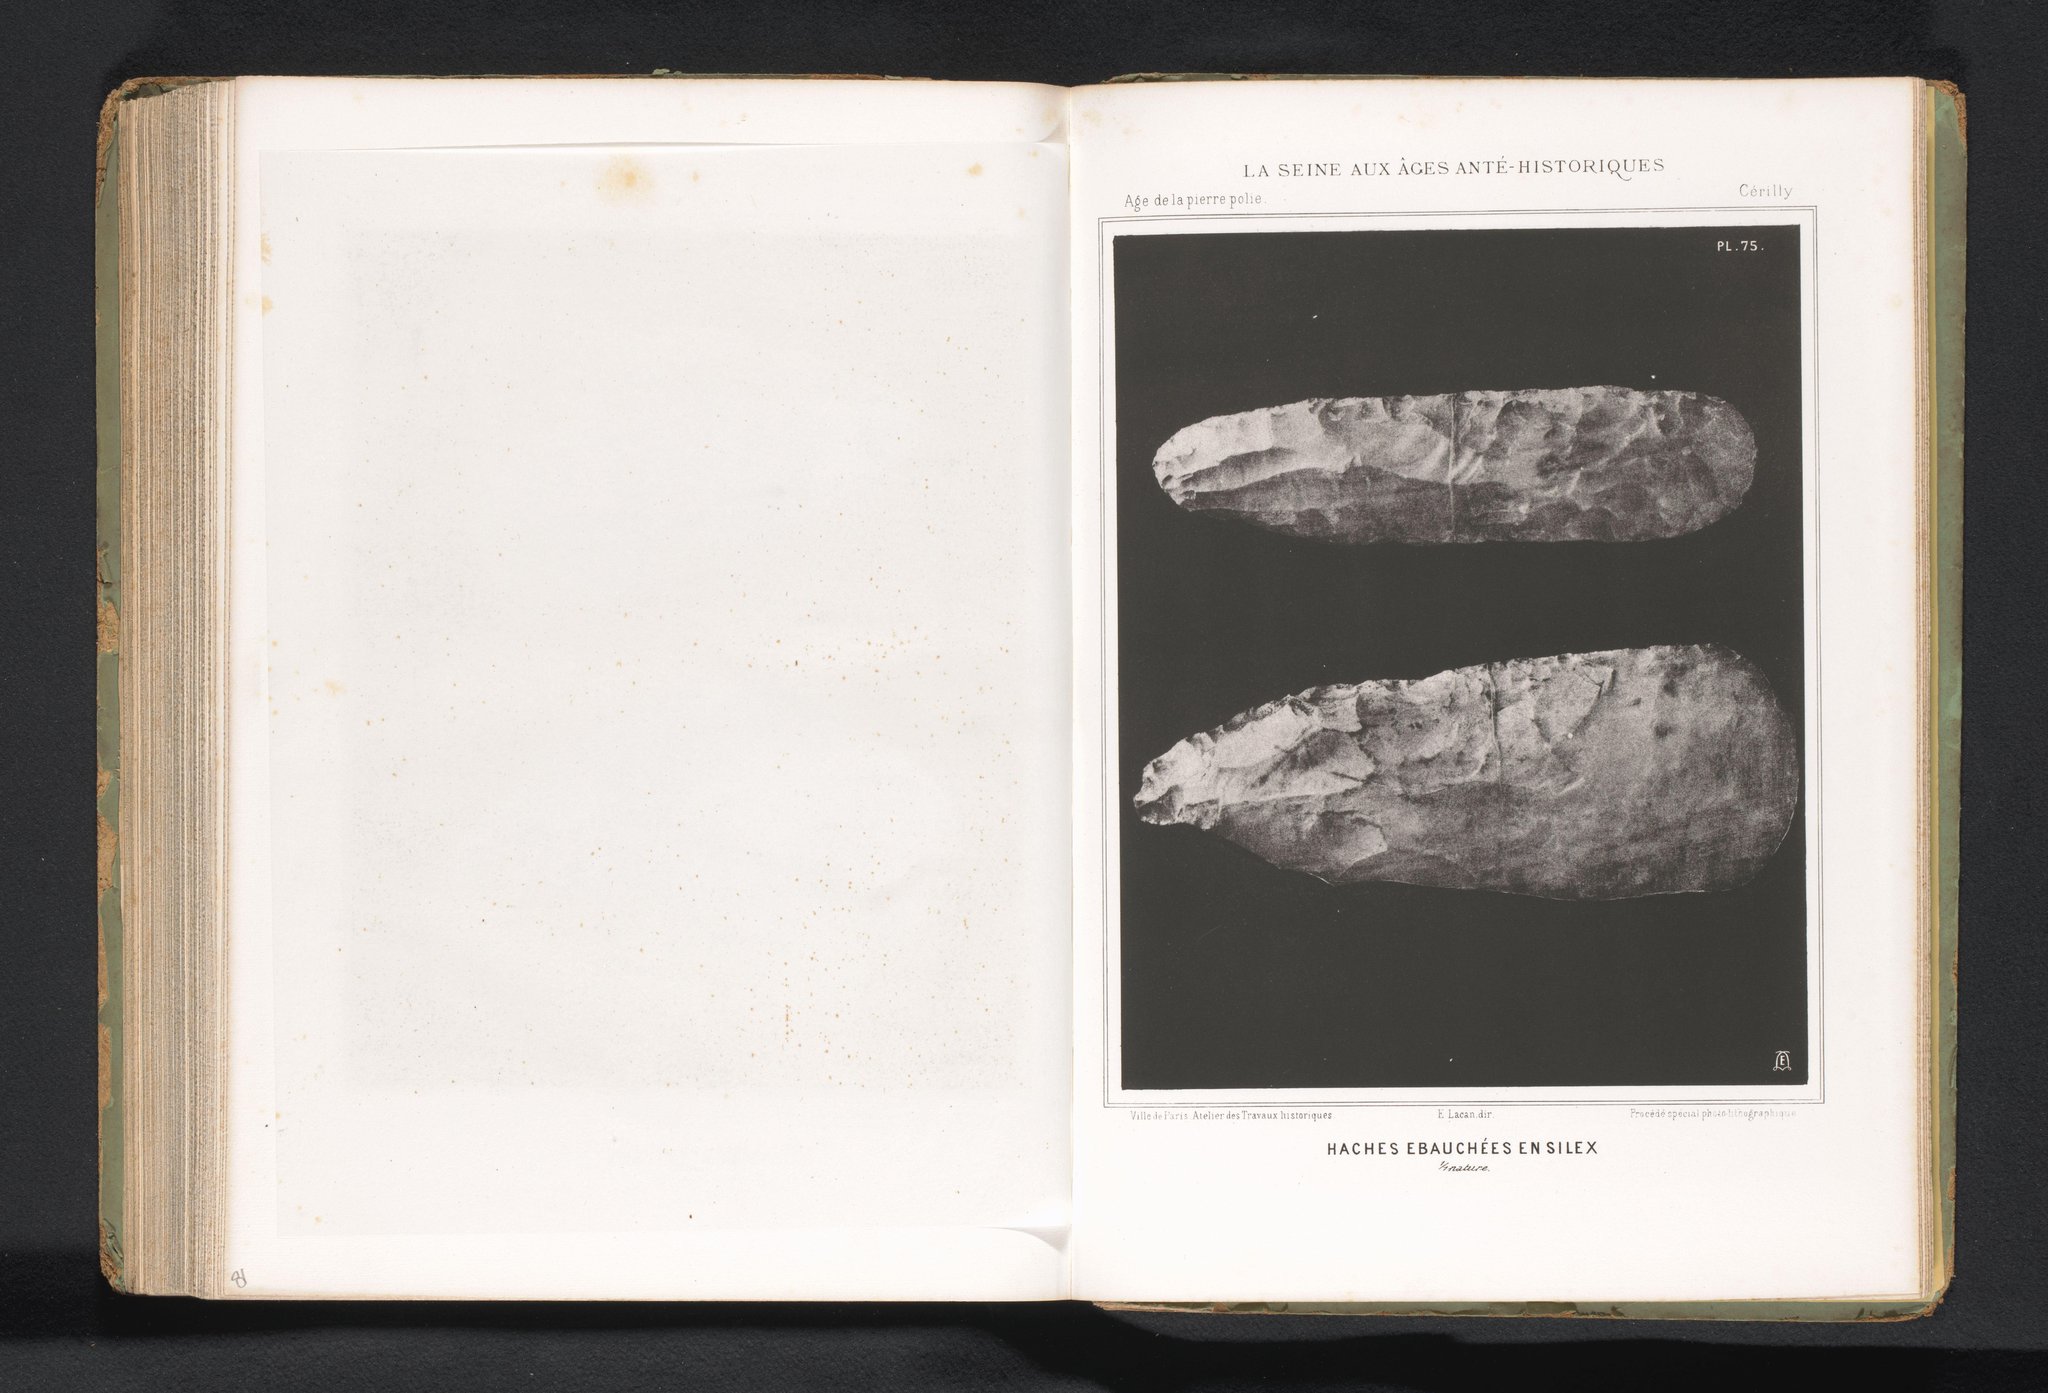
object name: page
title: Haches ebauchées en silex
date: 1864-1869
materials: paper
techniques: photolithography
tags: tools, aids, implements ~ crafts and industries: axe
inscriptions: inscription: ‘1/1 nature’, monogram: ‘EL’, inscription: ‘PL.75’, inscription: ‘Procédé spécial photo-lithographique’